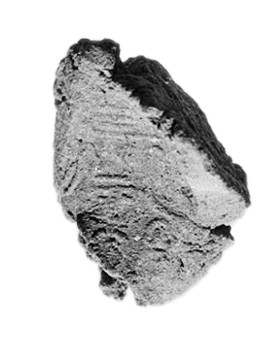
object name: sealing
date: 1981-1640 BCE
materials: mud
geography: egypt